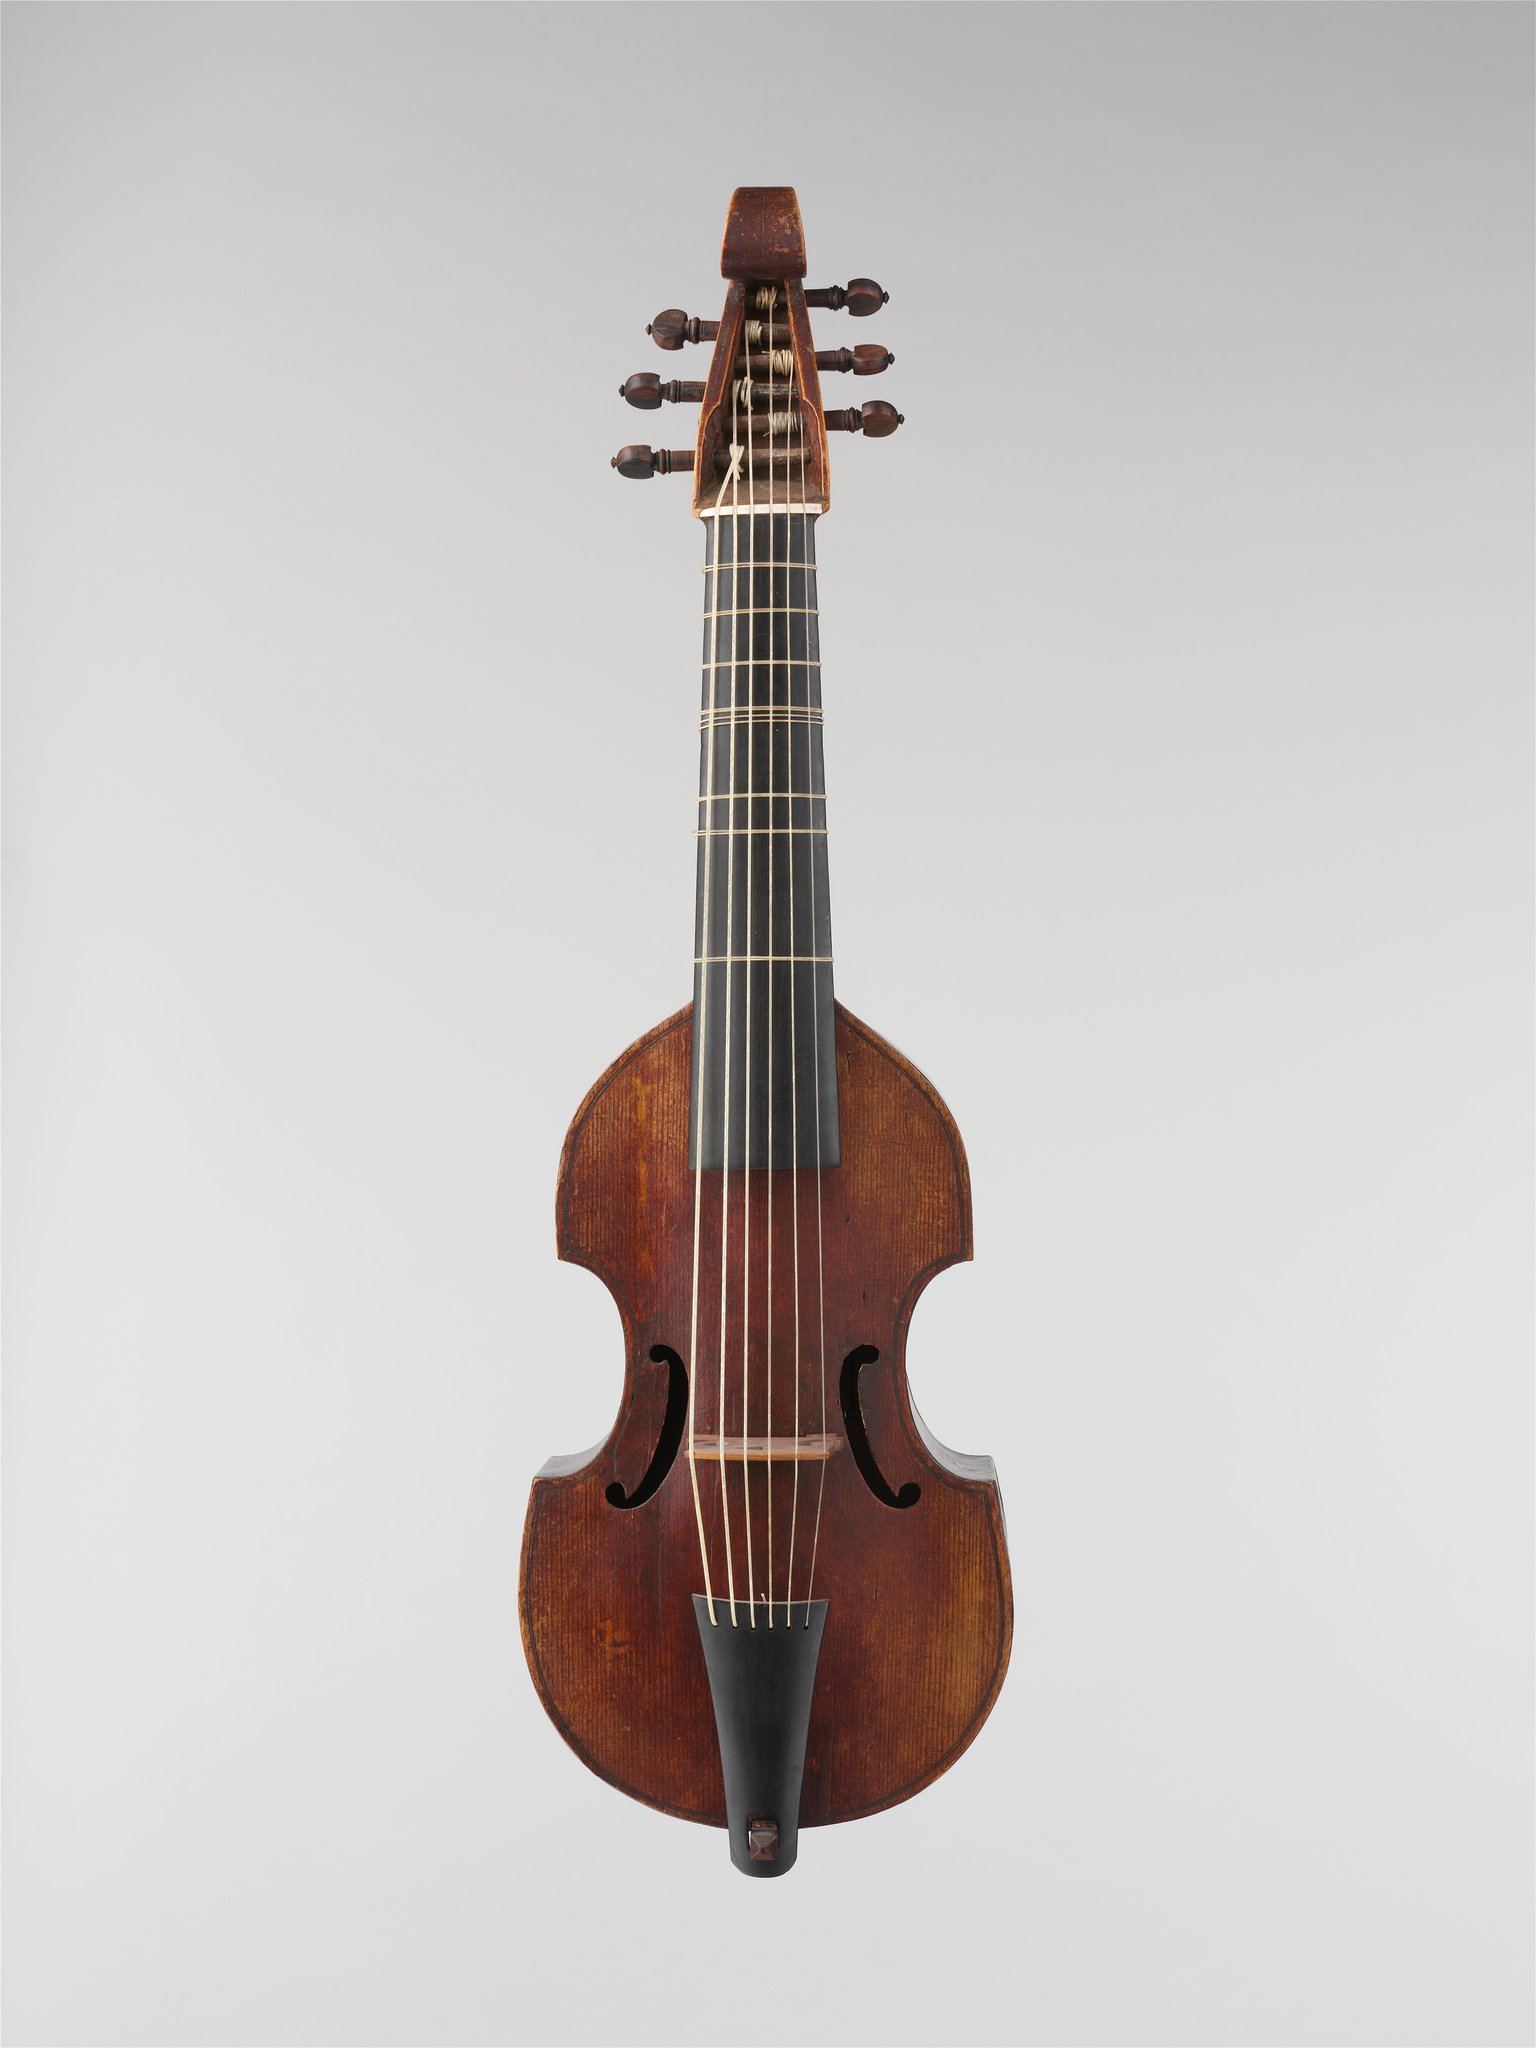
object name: treble viol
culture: french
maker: jean ouvrard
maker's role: maker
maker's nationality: french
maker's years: 1720-1748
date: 1726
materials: wood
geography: france